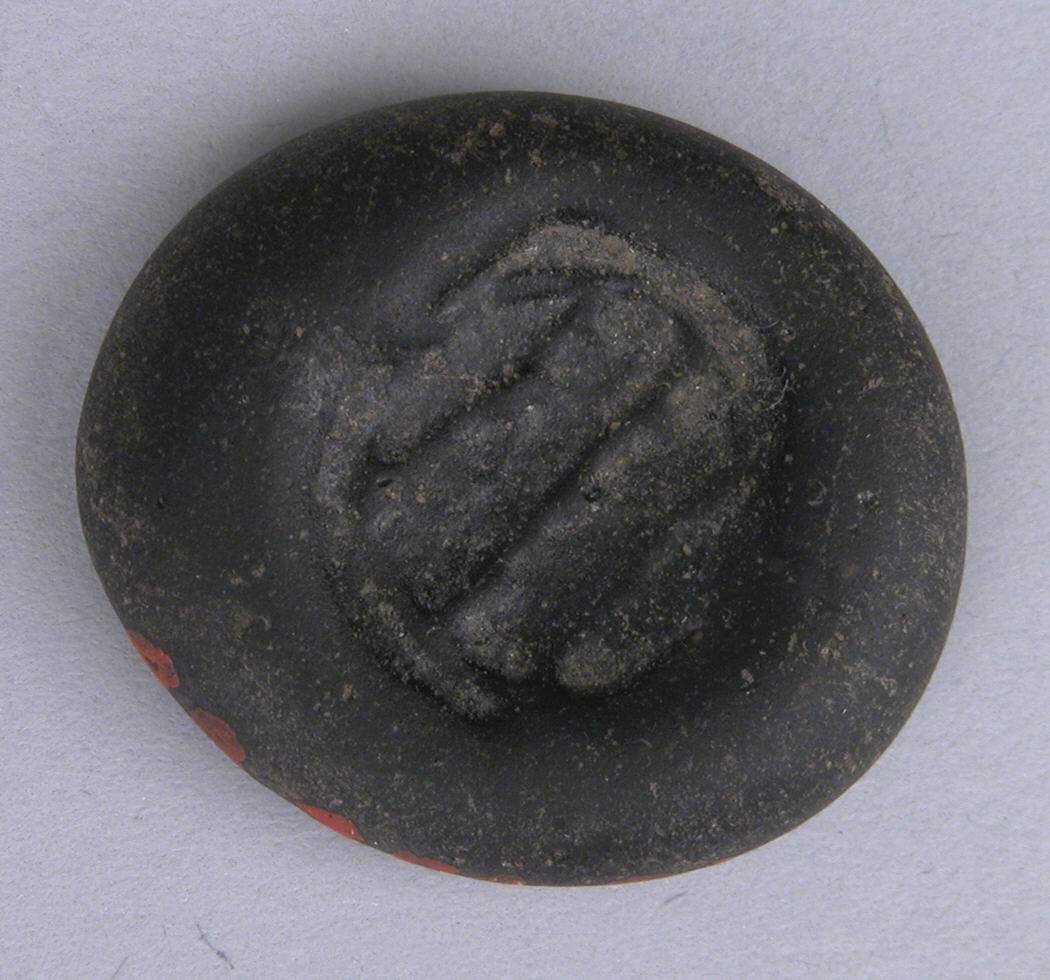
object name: coin weight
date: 1201-1400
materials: glass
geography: egypt